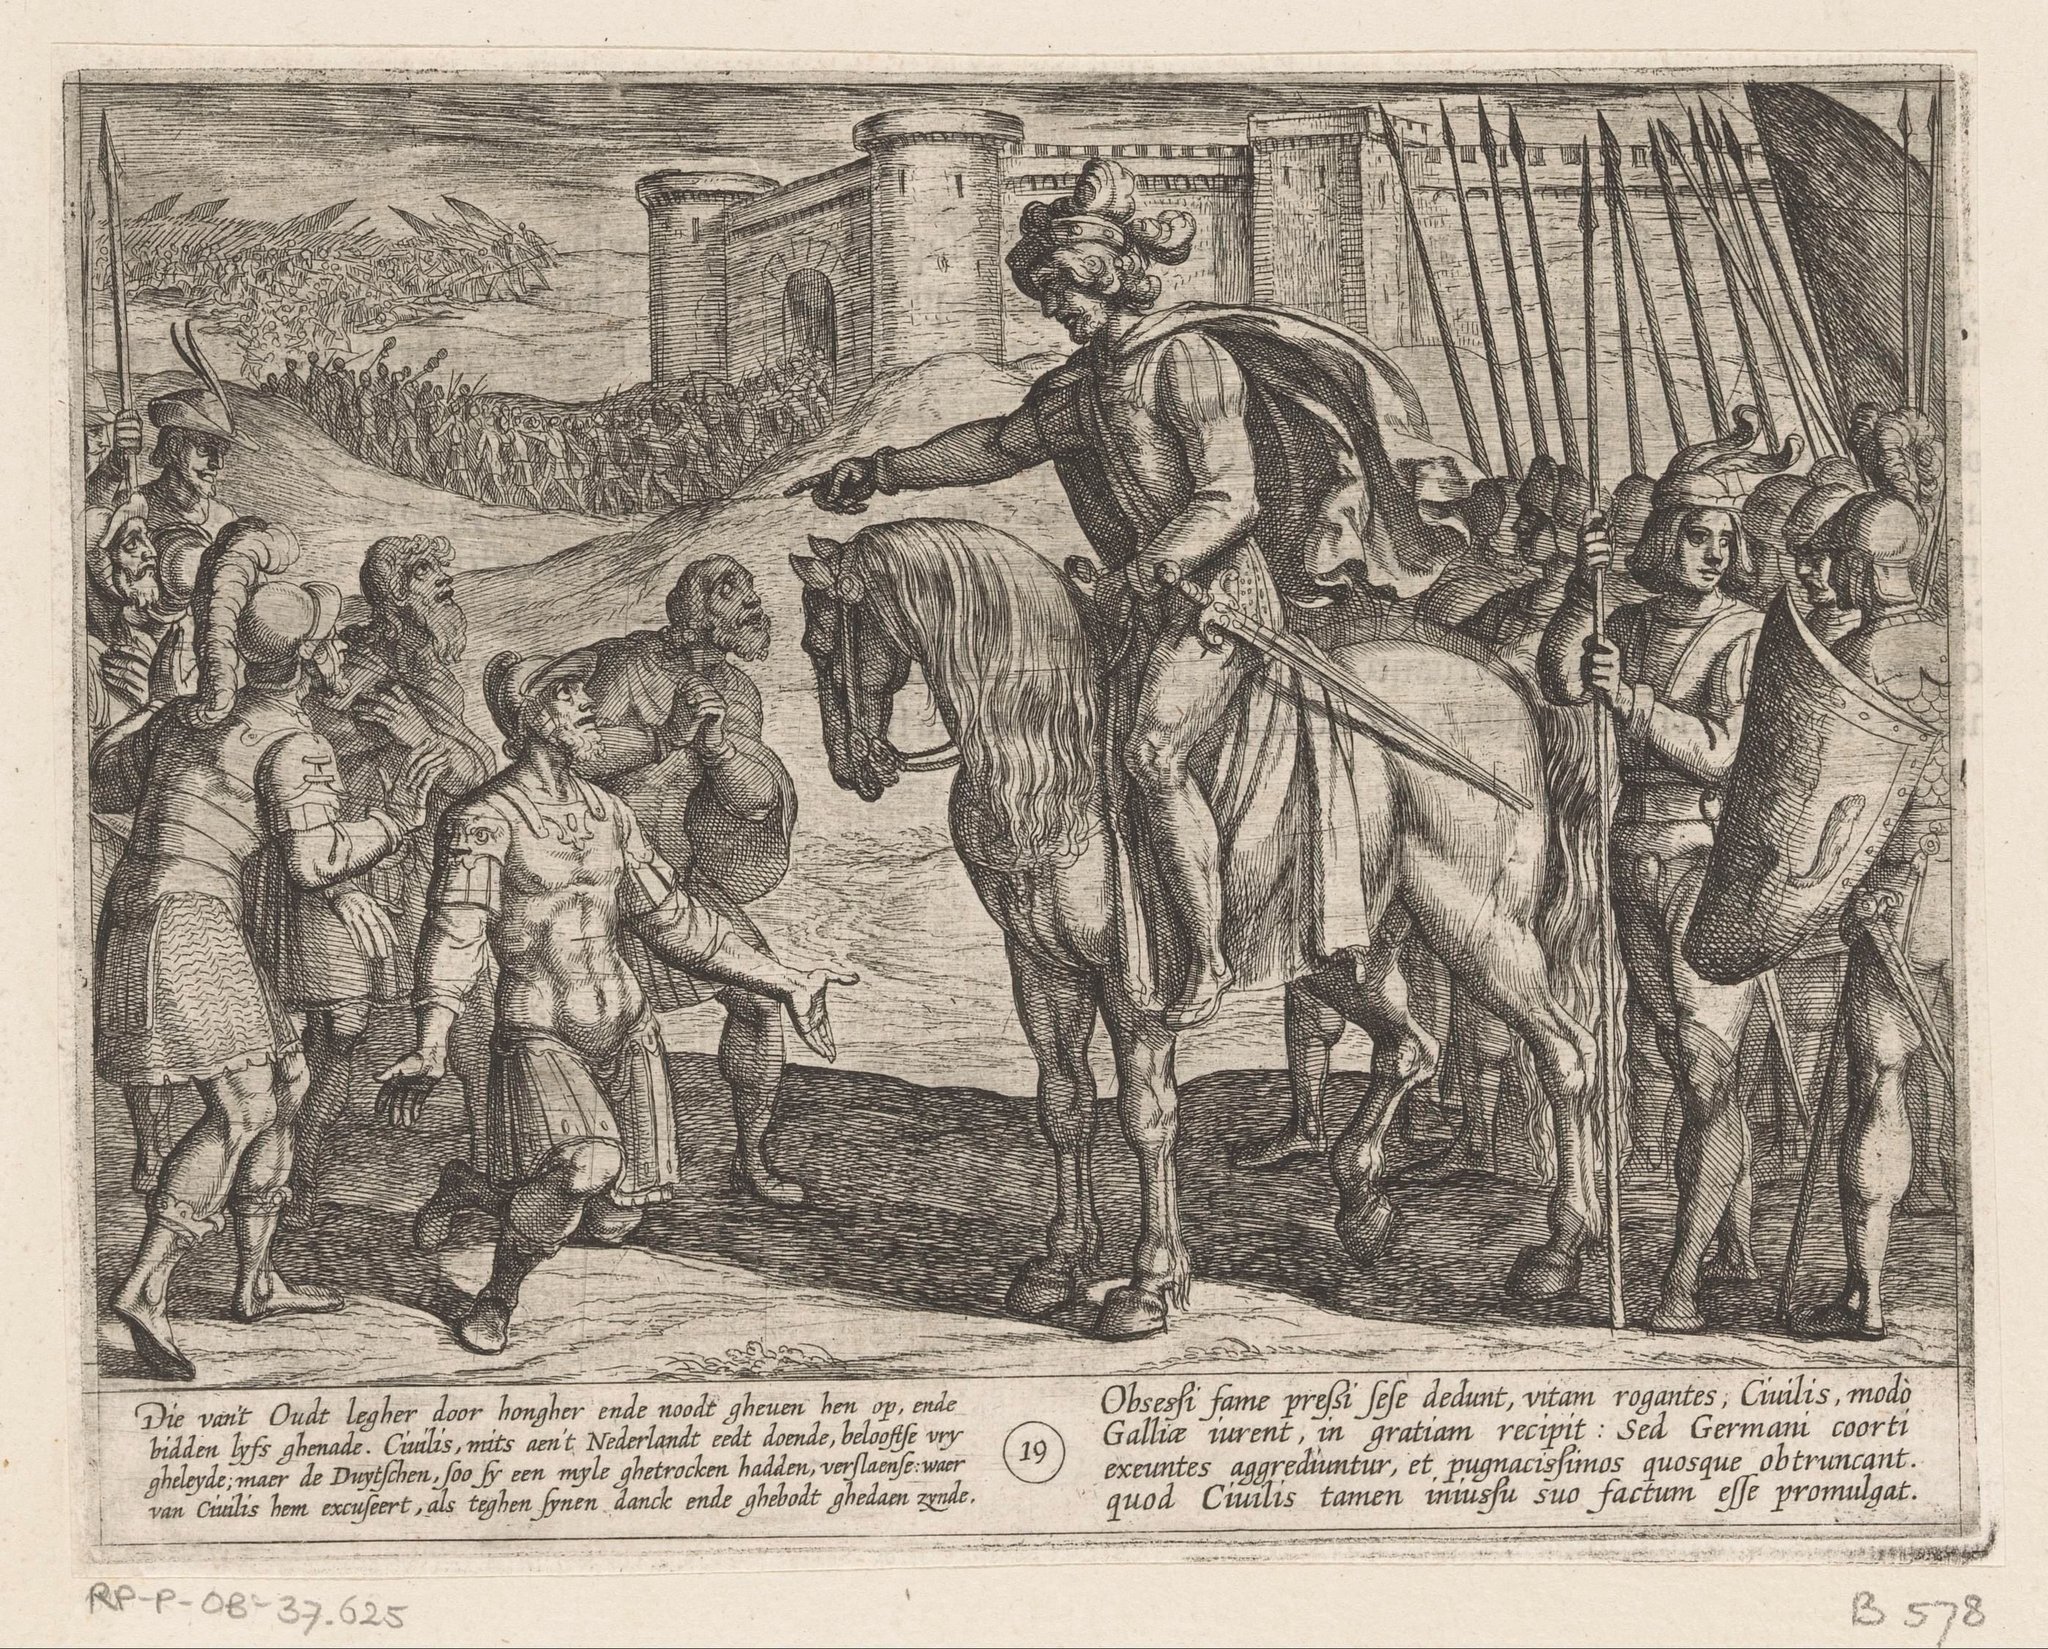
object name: print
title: De Bataafse oorlogen tegen de Romeinen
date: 1611-1612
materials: paper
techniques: etching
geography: southern netherlands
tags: surrender ~ prisoner of war, the soldier; the soldier's life, (story of) julius claudius civilis, prisoner of war (after the battle), extinct, 'historical' peoples (with name)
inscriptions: collector's mark: Lugt 240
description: Romeinse mannen uit het verslagen fort (Castra Vetera) geven zich over aan Julius Civilis. Julius Civilis belooft hun levens te sparen. Op de achtergrond doden de Duitse troepen echter de ongewapende gevangenen. Onderschrift in het Nederlands en in het Latijn.